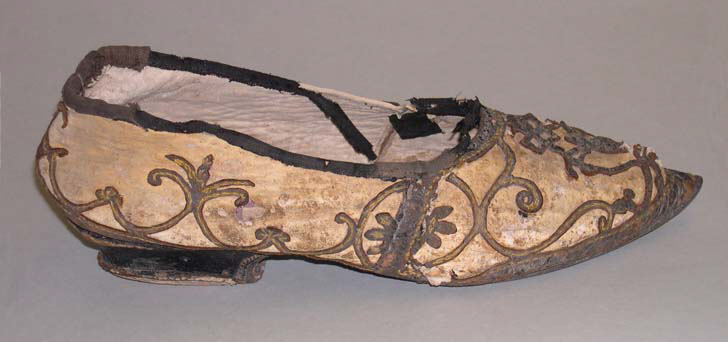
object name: slipper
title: Slippers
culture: italian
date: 1780-1799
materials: leather